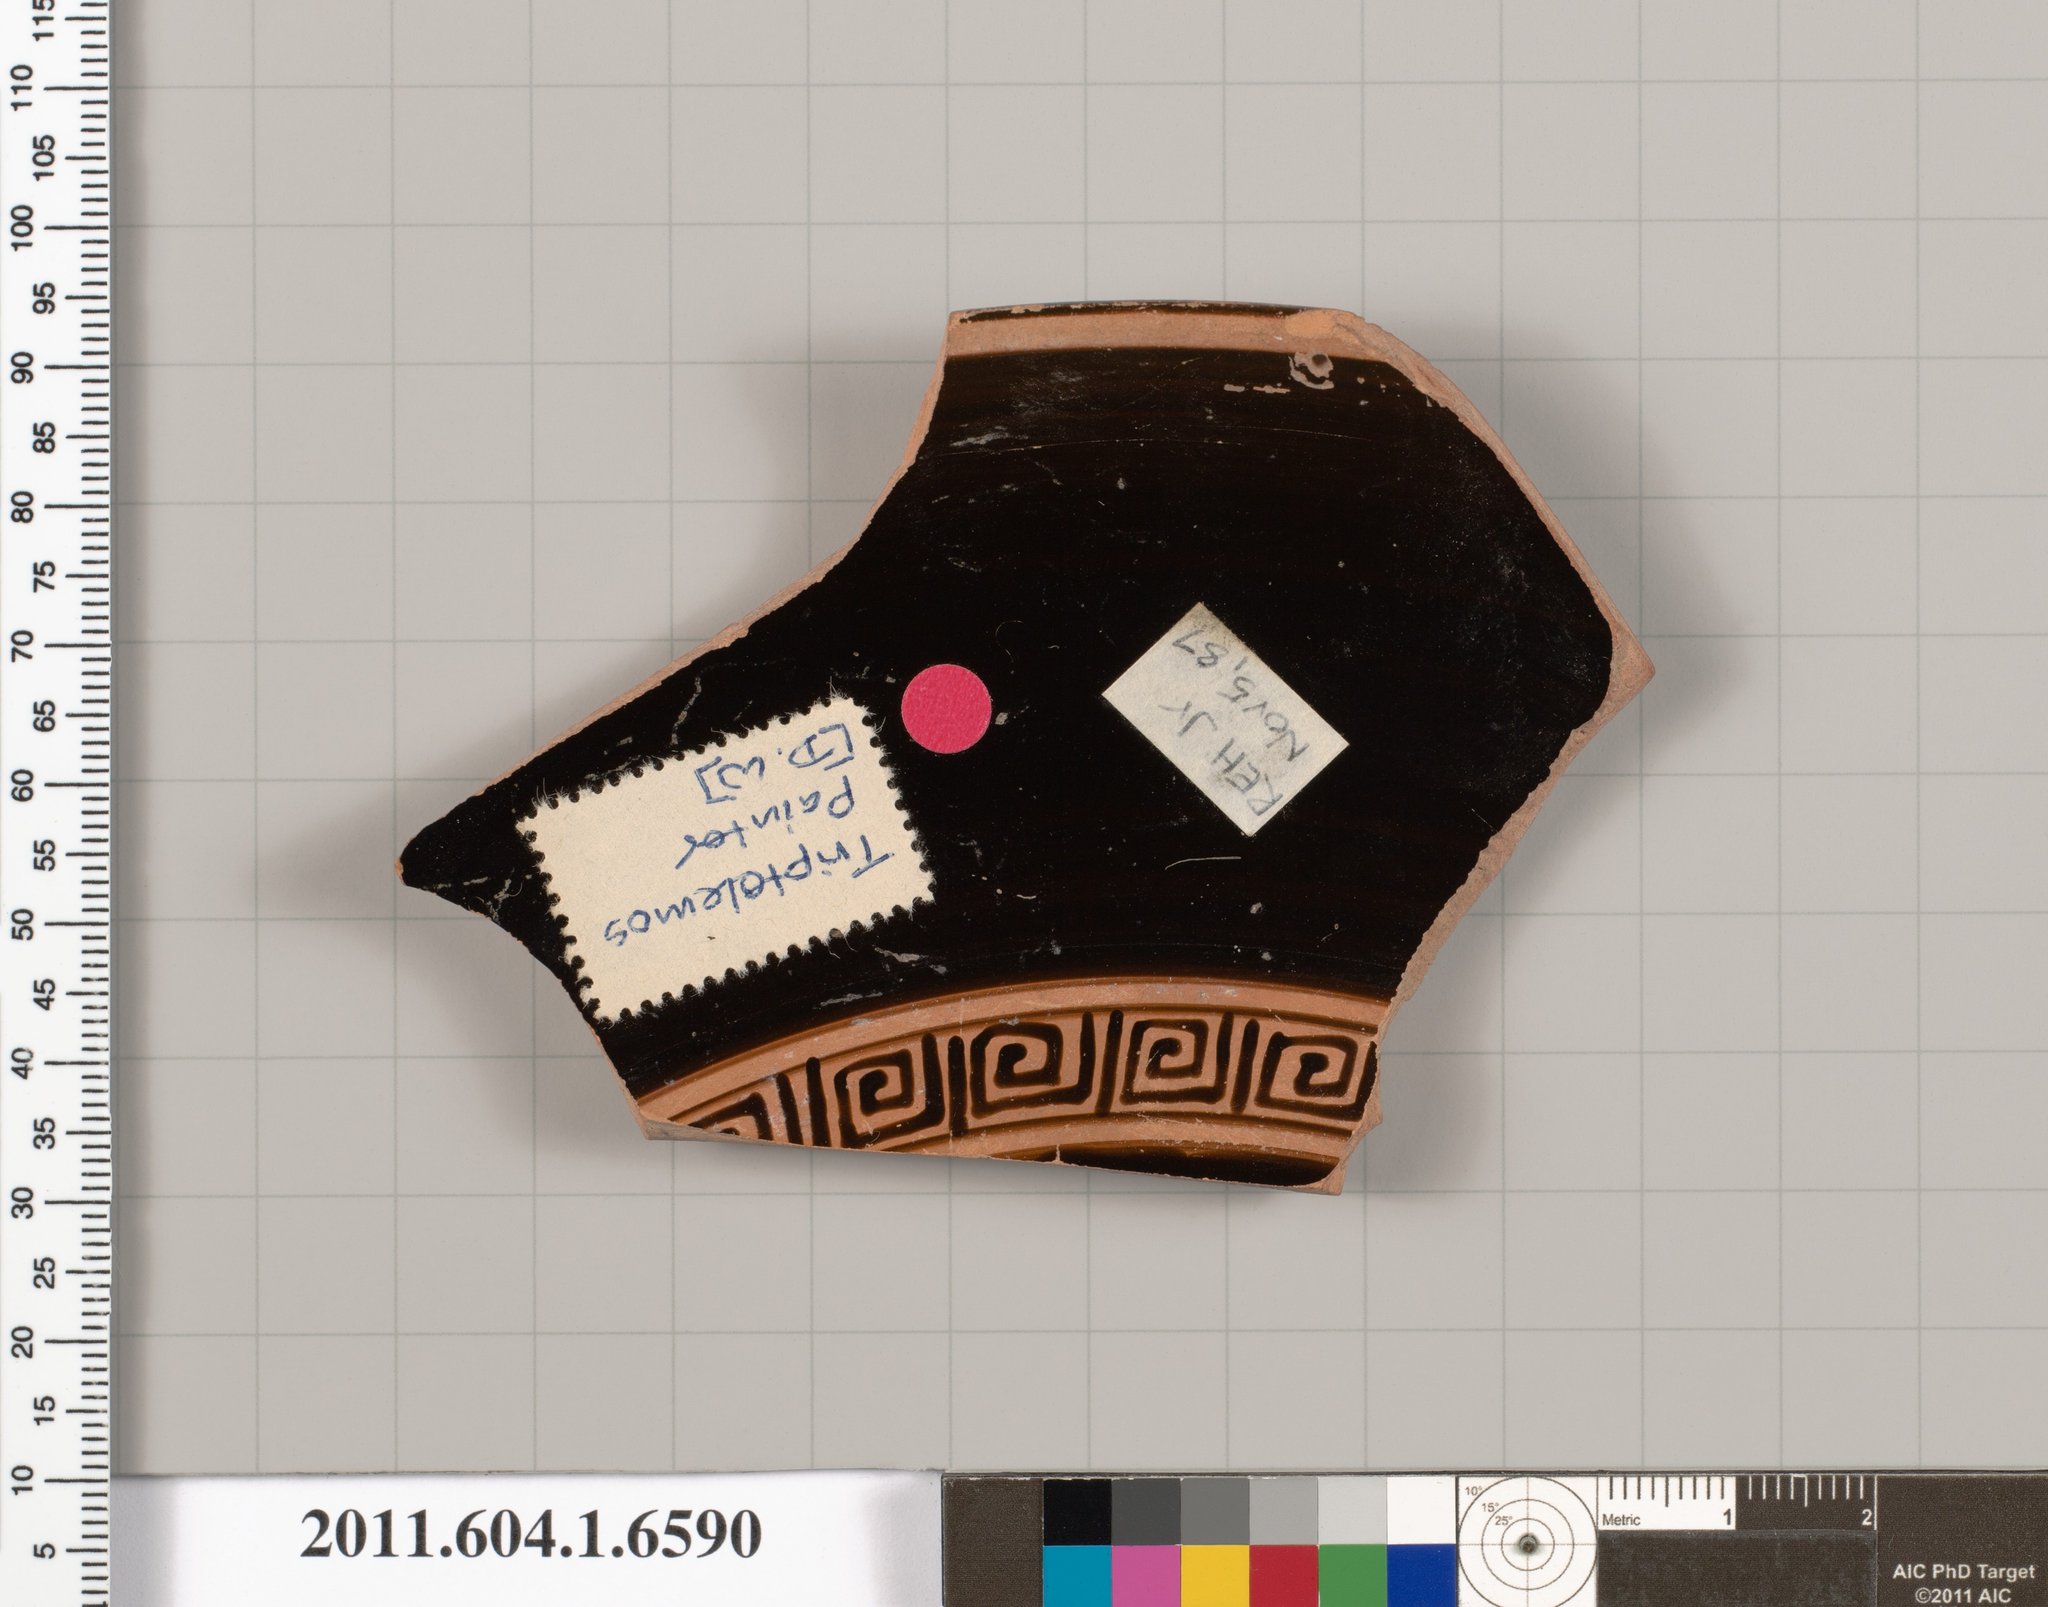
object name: kylix fragment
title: Terracotta fragment of a kylix (drinking cup)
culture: greek, attic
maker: triptolemos painter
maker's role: artist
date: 490-480 BCE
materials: terracotta